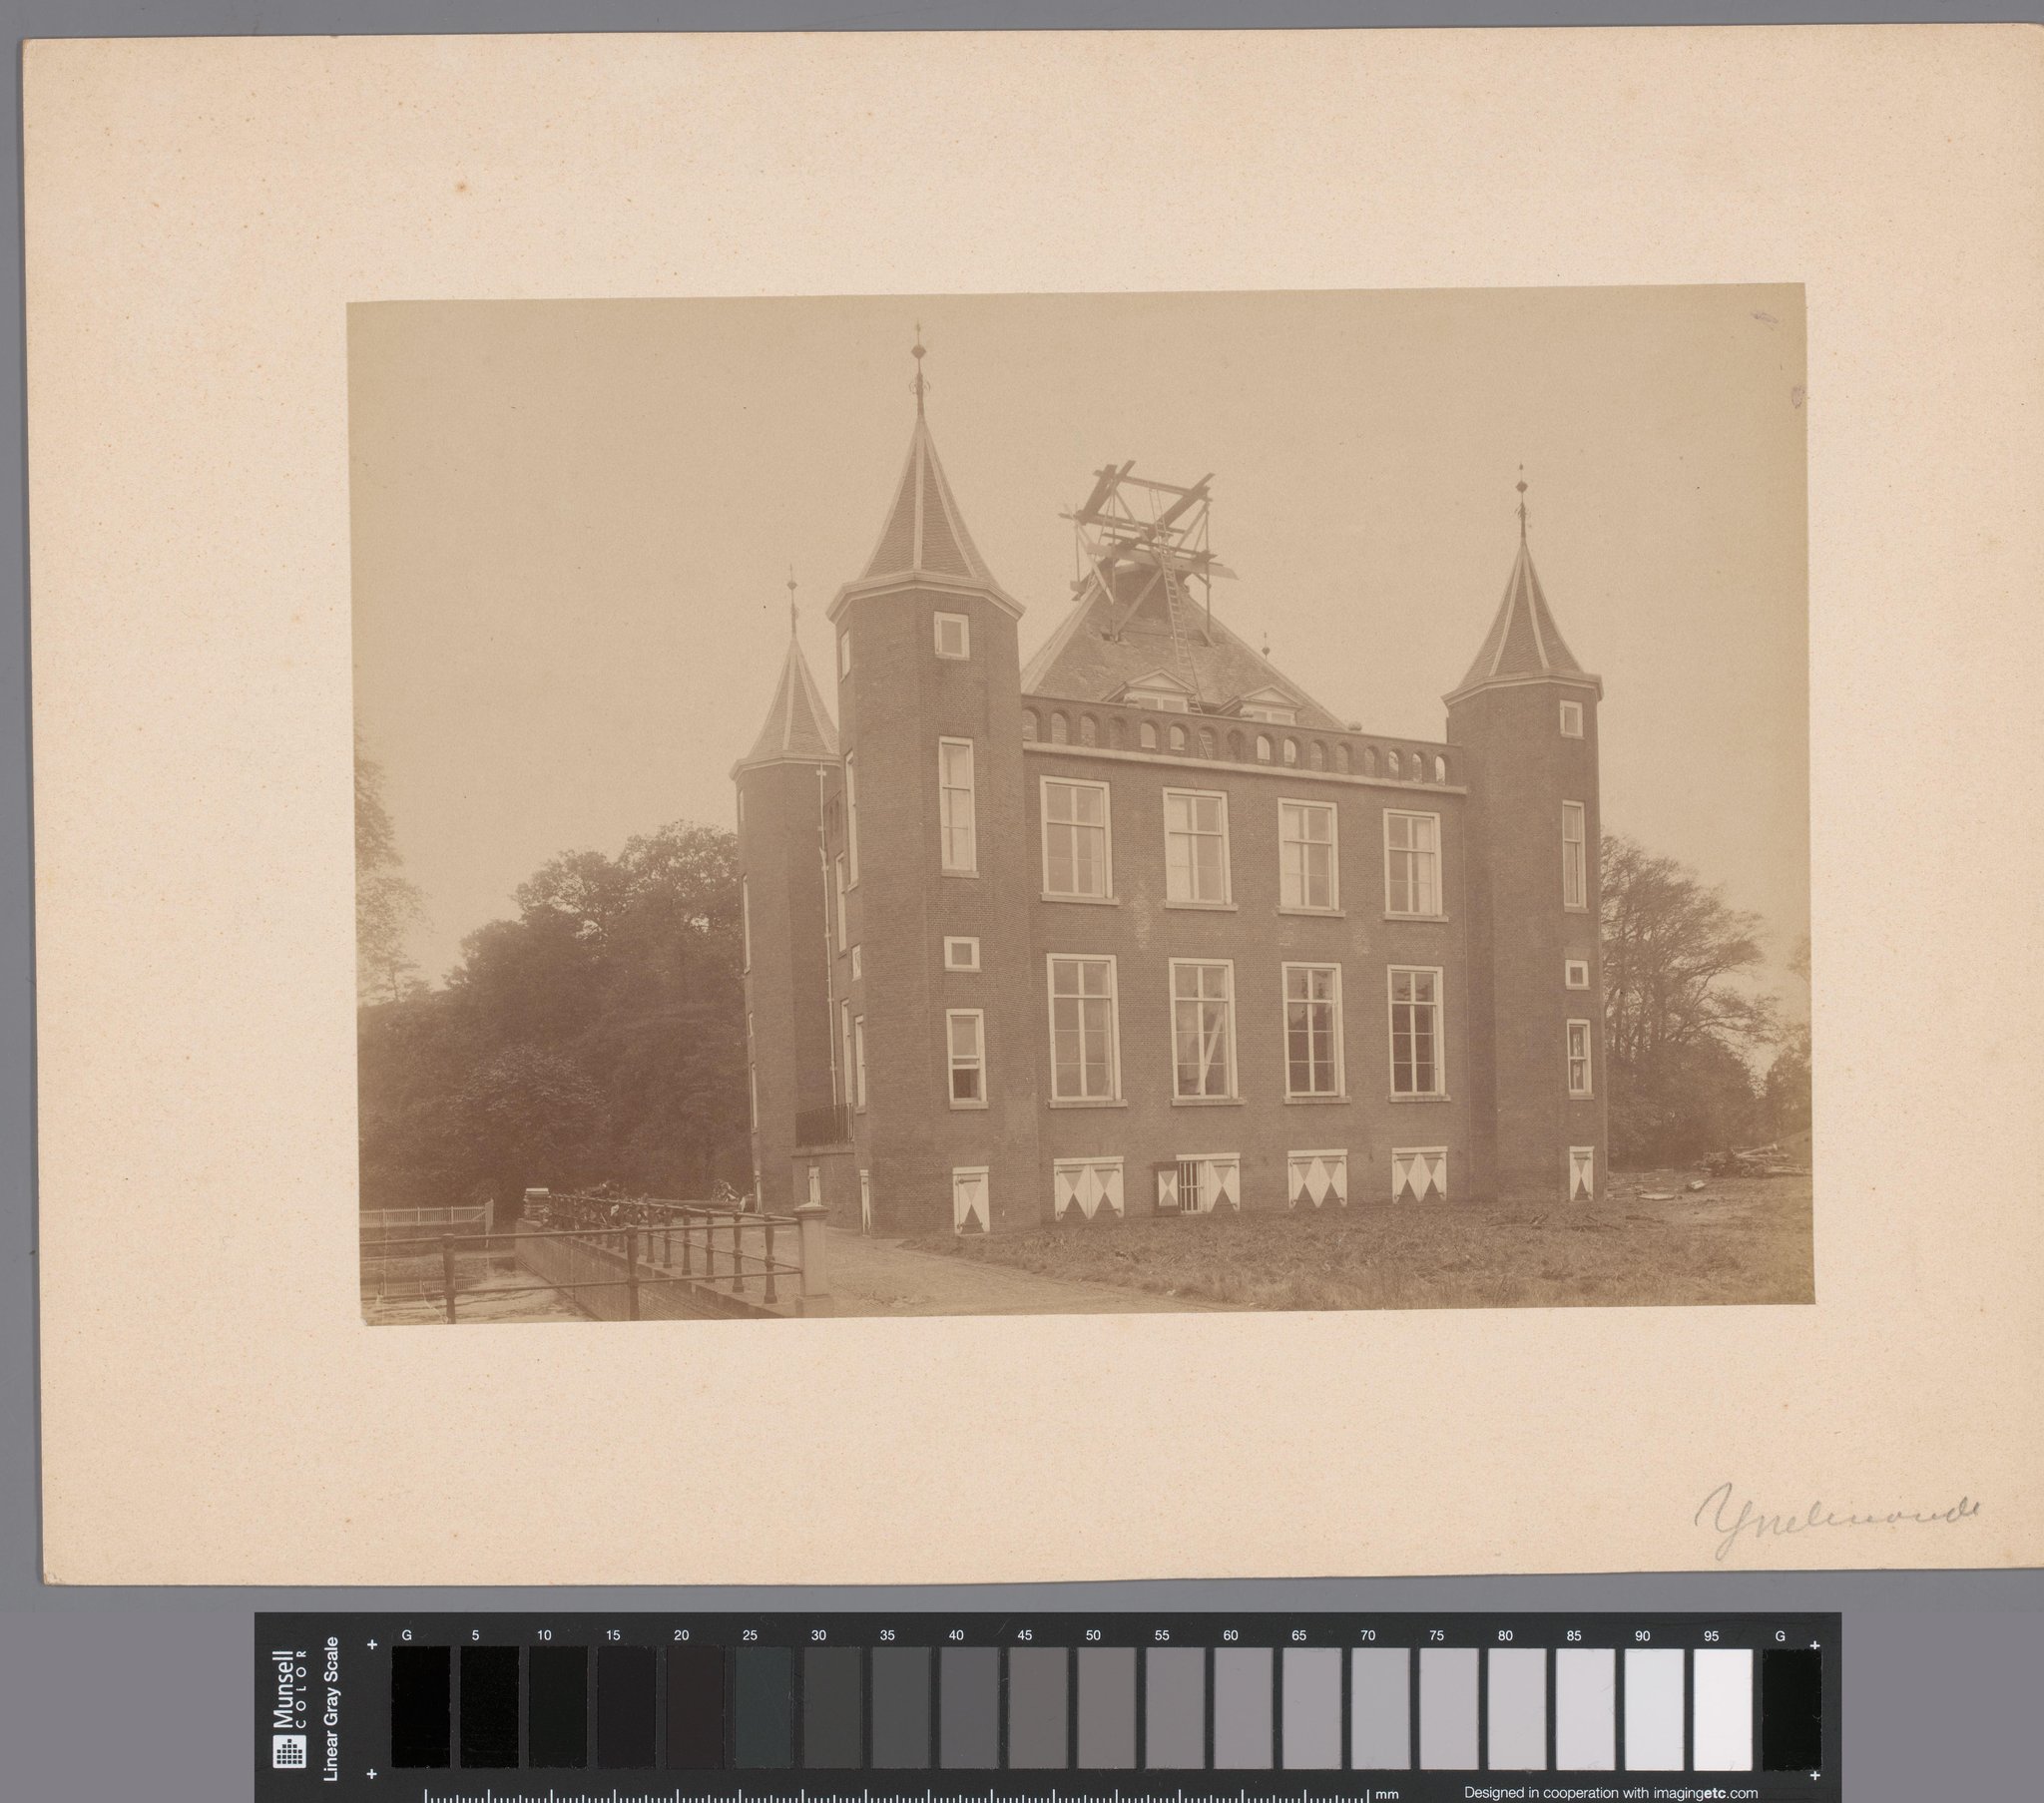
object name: photograph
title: Noordzijde van Kasteel IJsselmonde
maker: anoniem (monumentenzorg)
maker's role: fotograaf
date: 1890-1920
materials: cardboard, photographic support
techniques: albumen print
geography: ijsselmonde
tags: castle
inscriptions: annotation: ‘Kasteel te Ijsselmonde (Z.H.)/ noordzijde’, annotation: ‘Ijsselmonde’